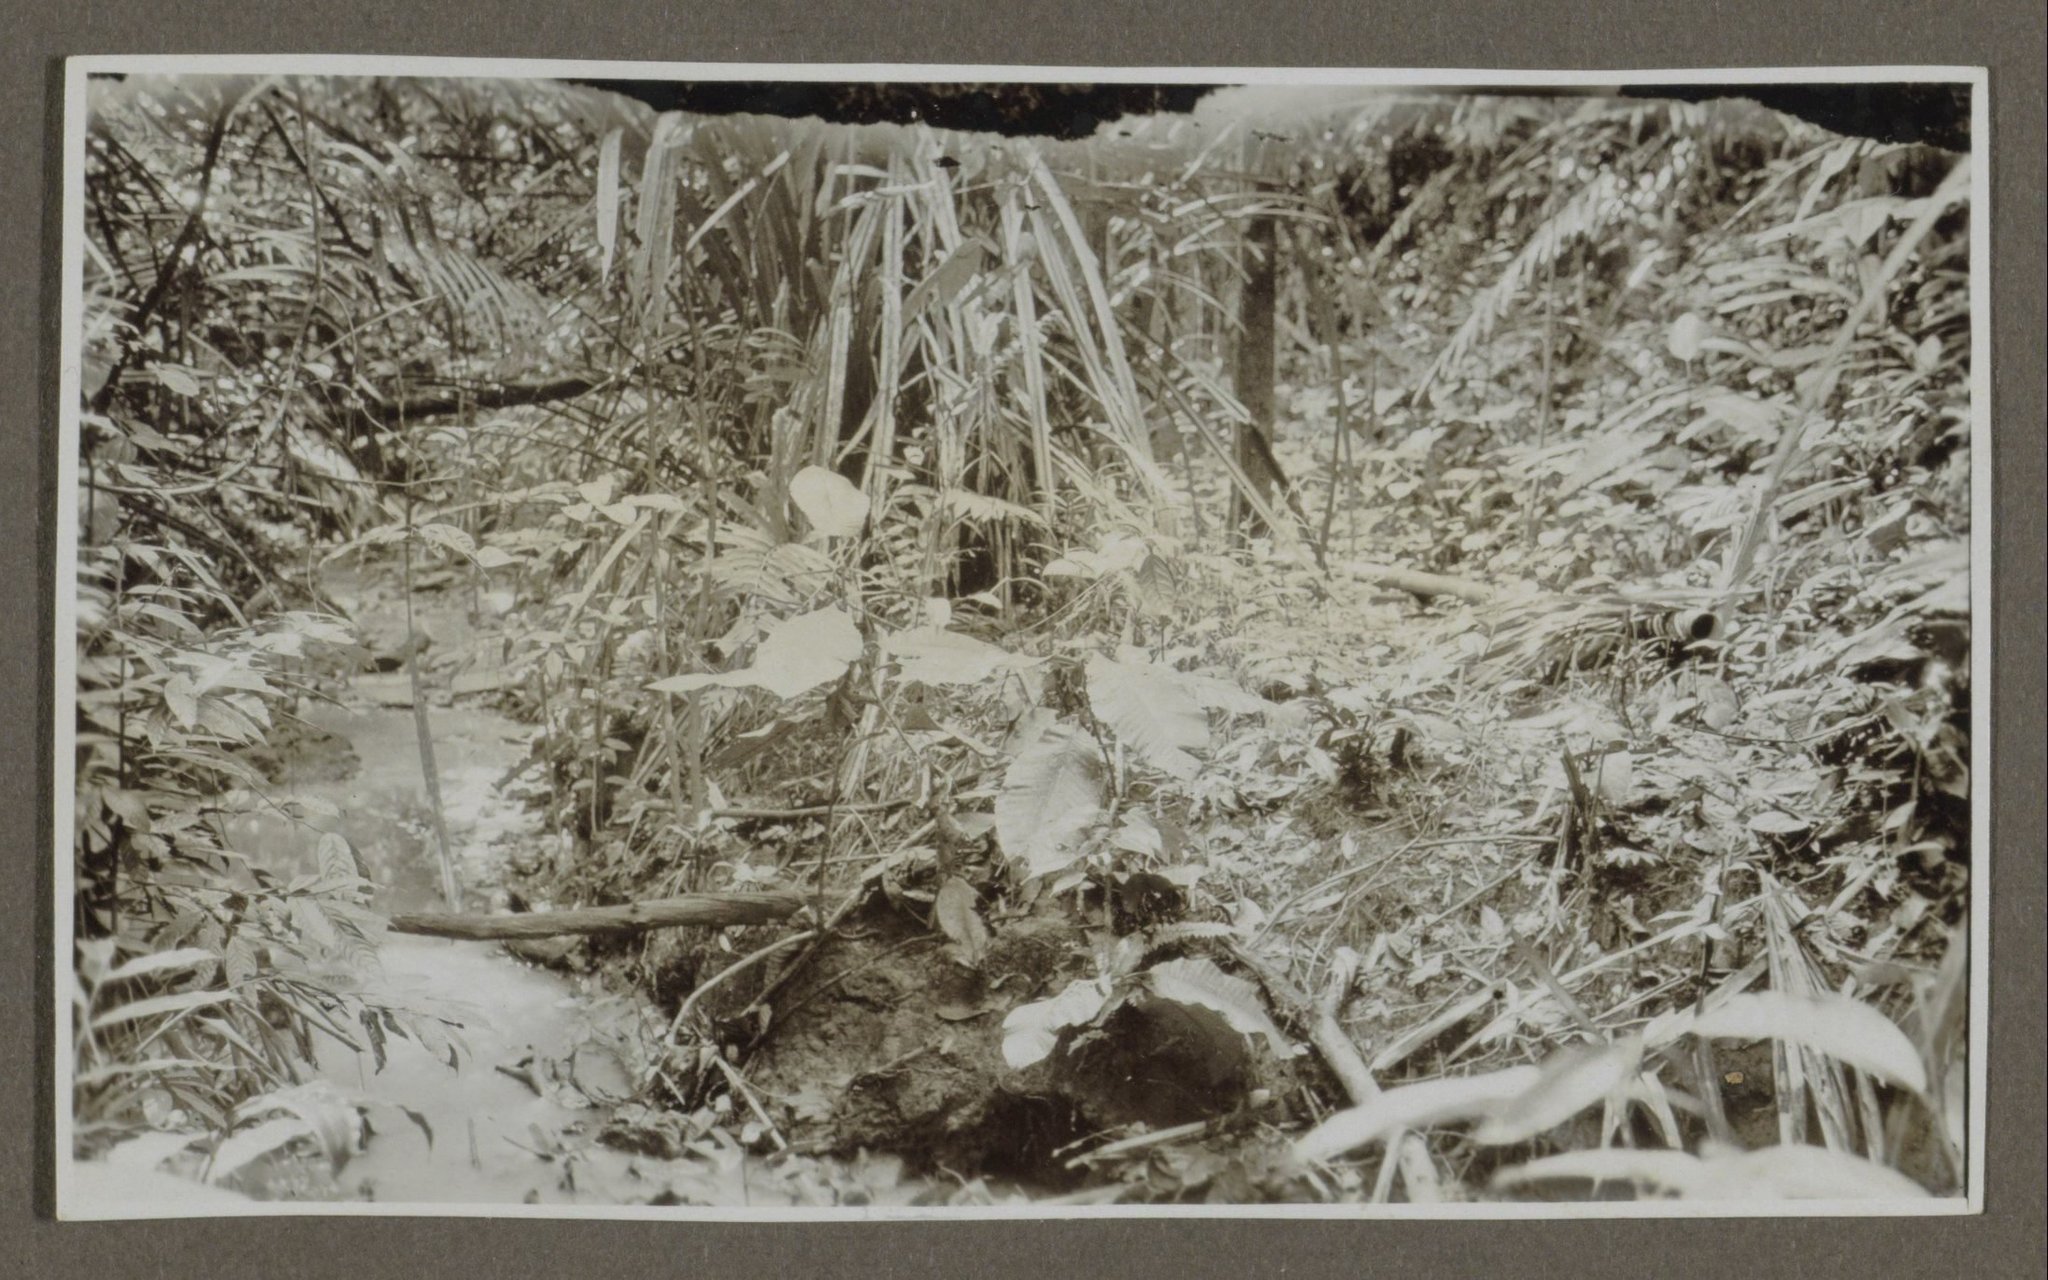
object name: photograph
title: Begroeiing aan de oever van een beekje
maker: Anonymous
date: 1920-1930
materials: photographic support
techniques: gelatin silver print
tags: plants; vegetation, brook, dutch east indies, the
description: Onderdeel van familiealbum Nederlands-Indië.